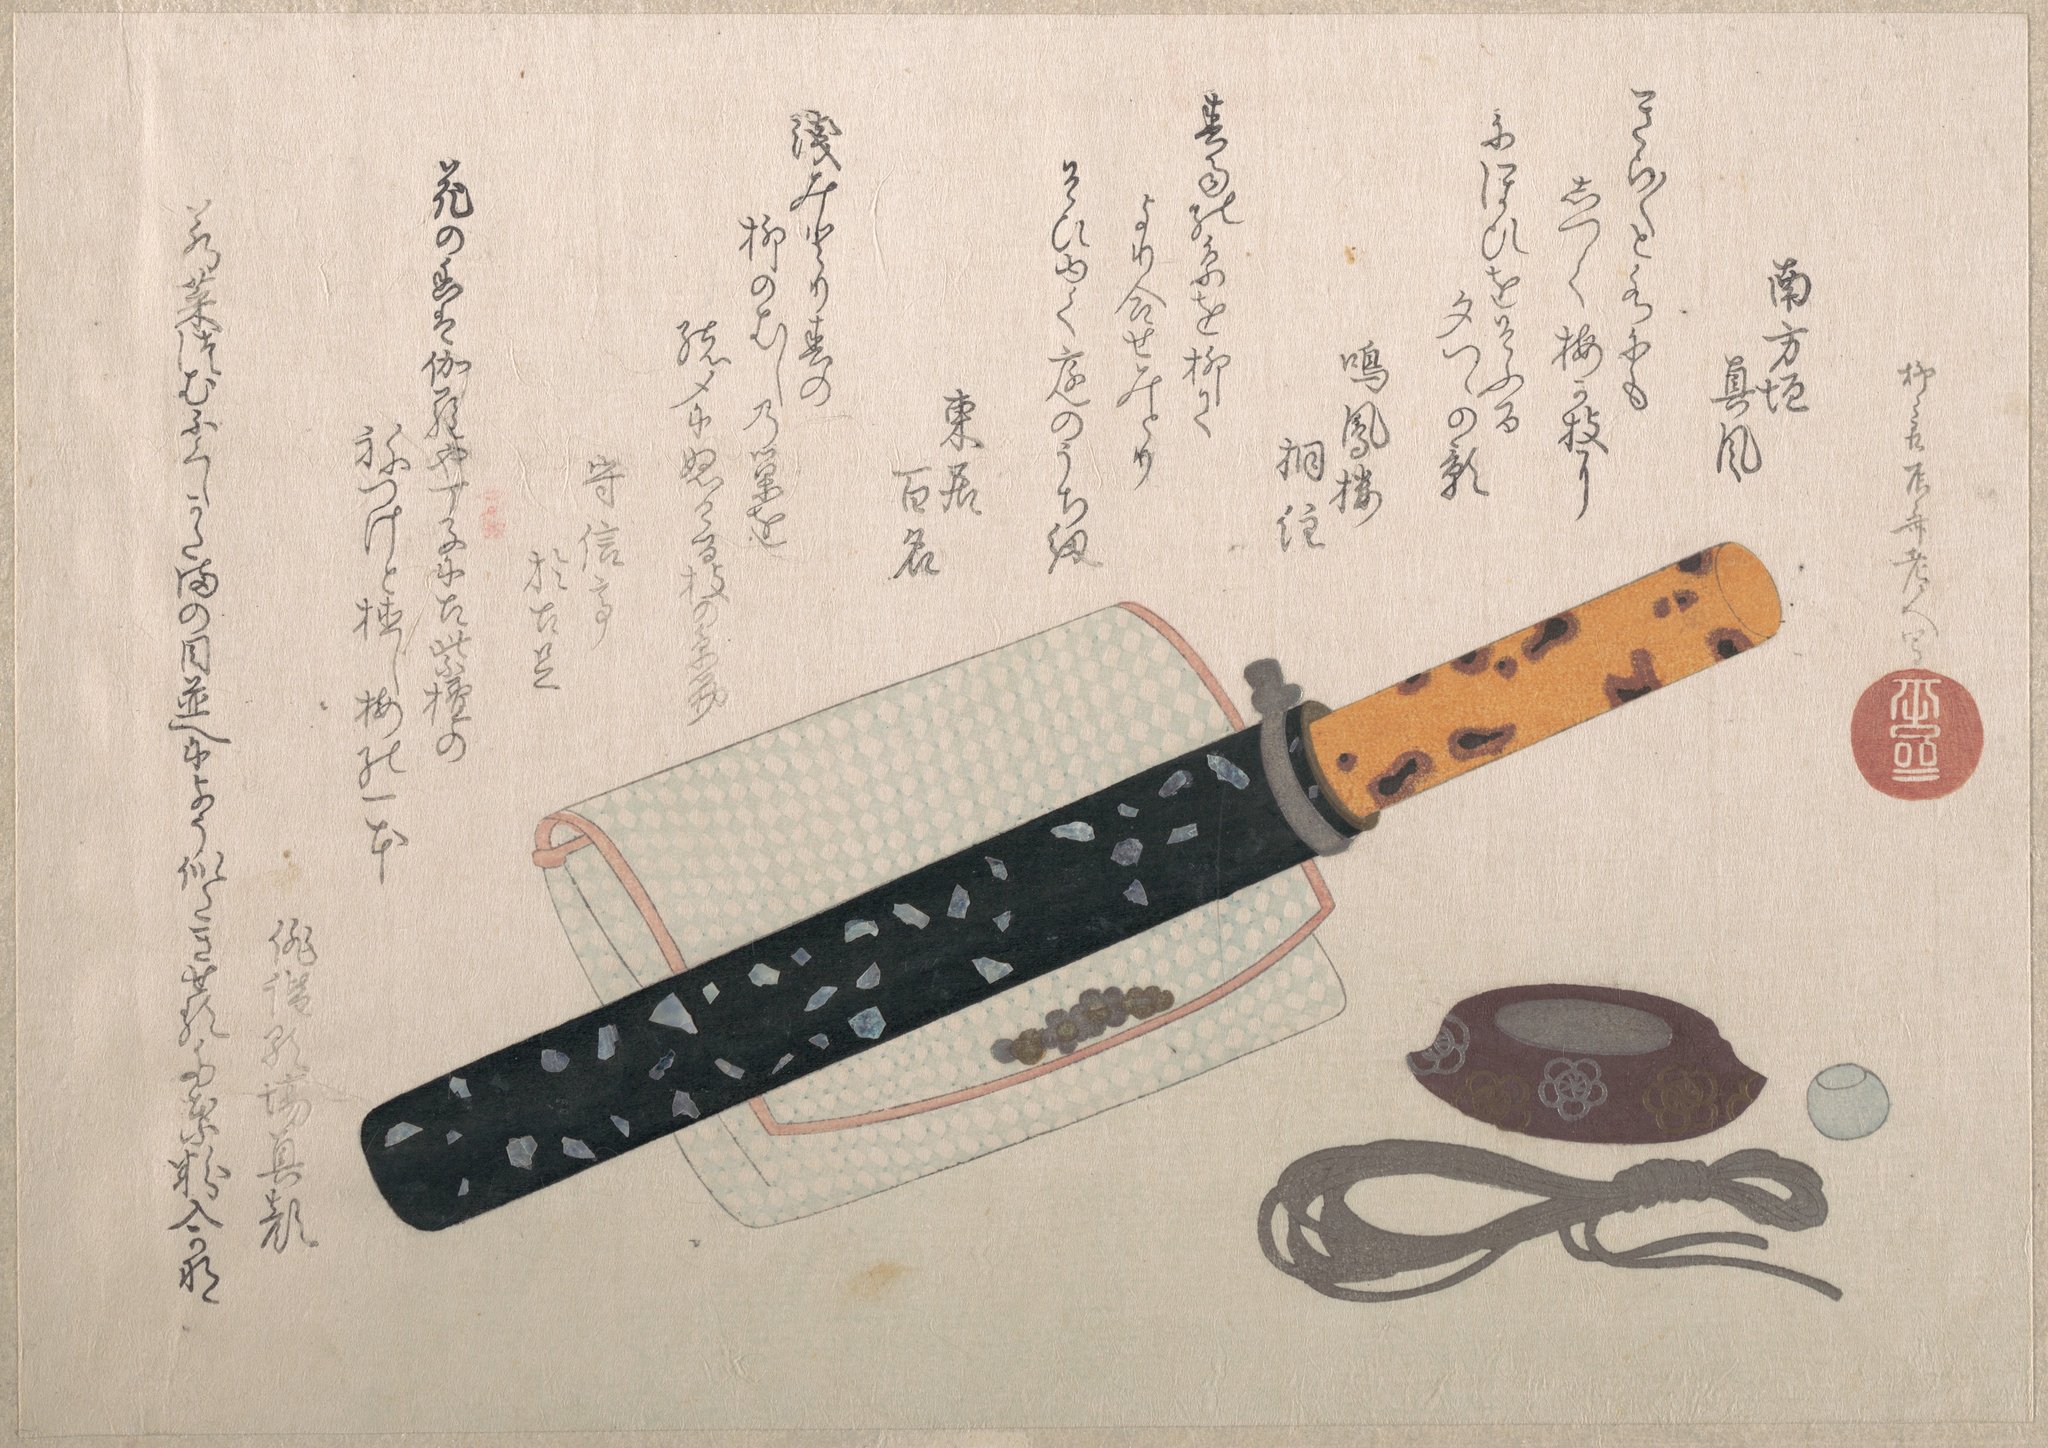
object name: print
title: Hanging Tobacco Set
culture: japanese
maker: ryūryūkyo shinsai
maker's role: artist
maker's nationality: japanese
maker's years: 1799-1823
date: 1801-1900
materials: ink, paper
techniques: surimono, woodblock print